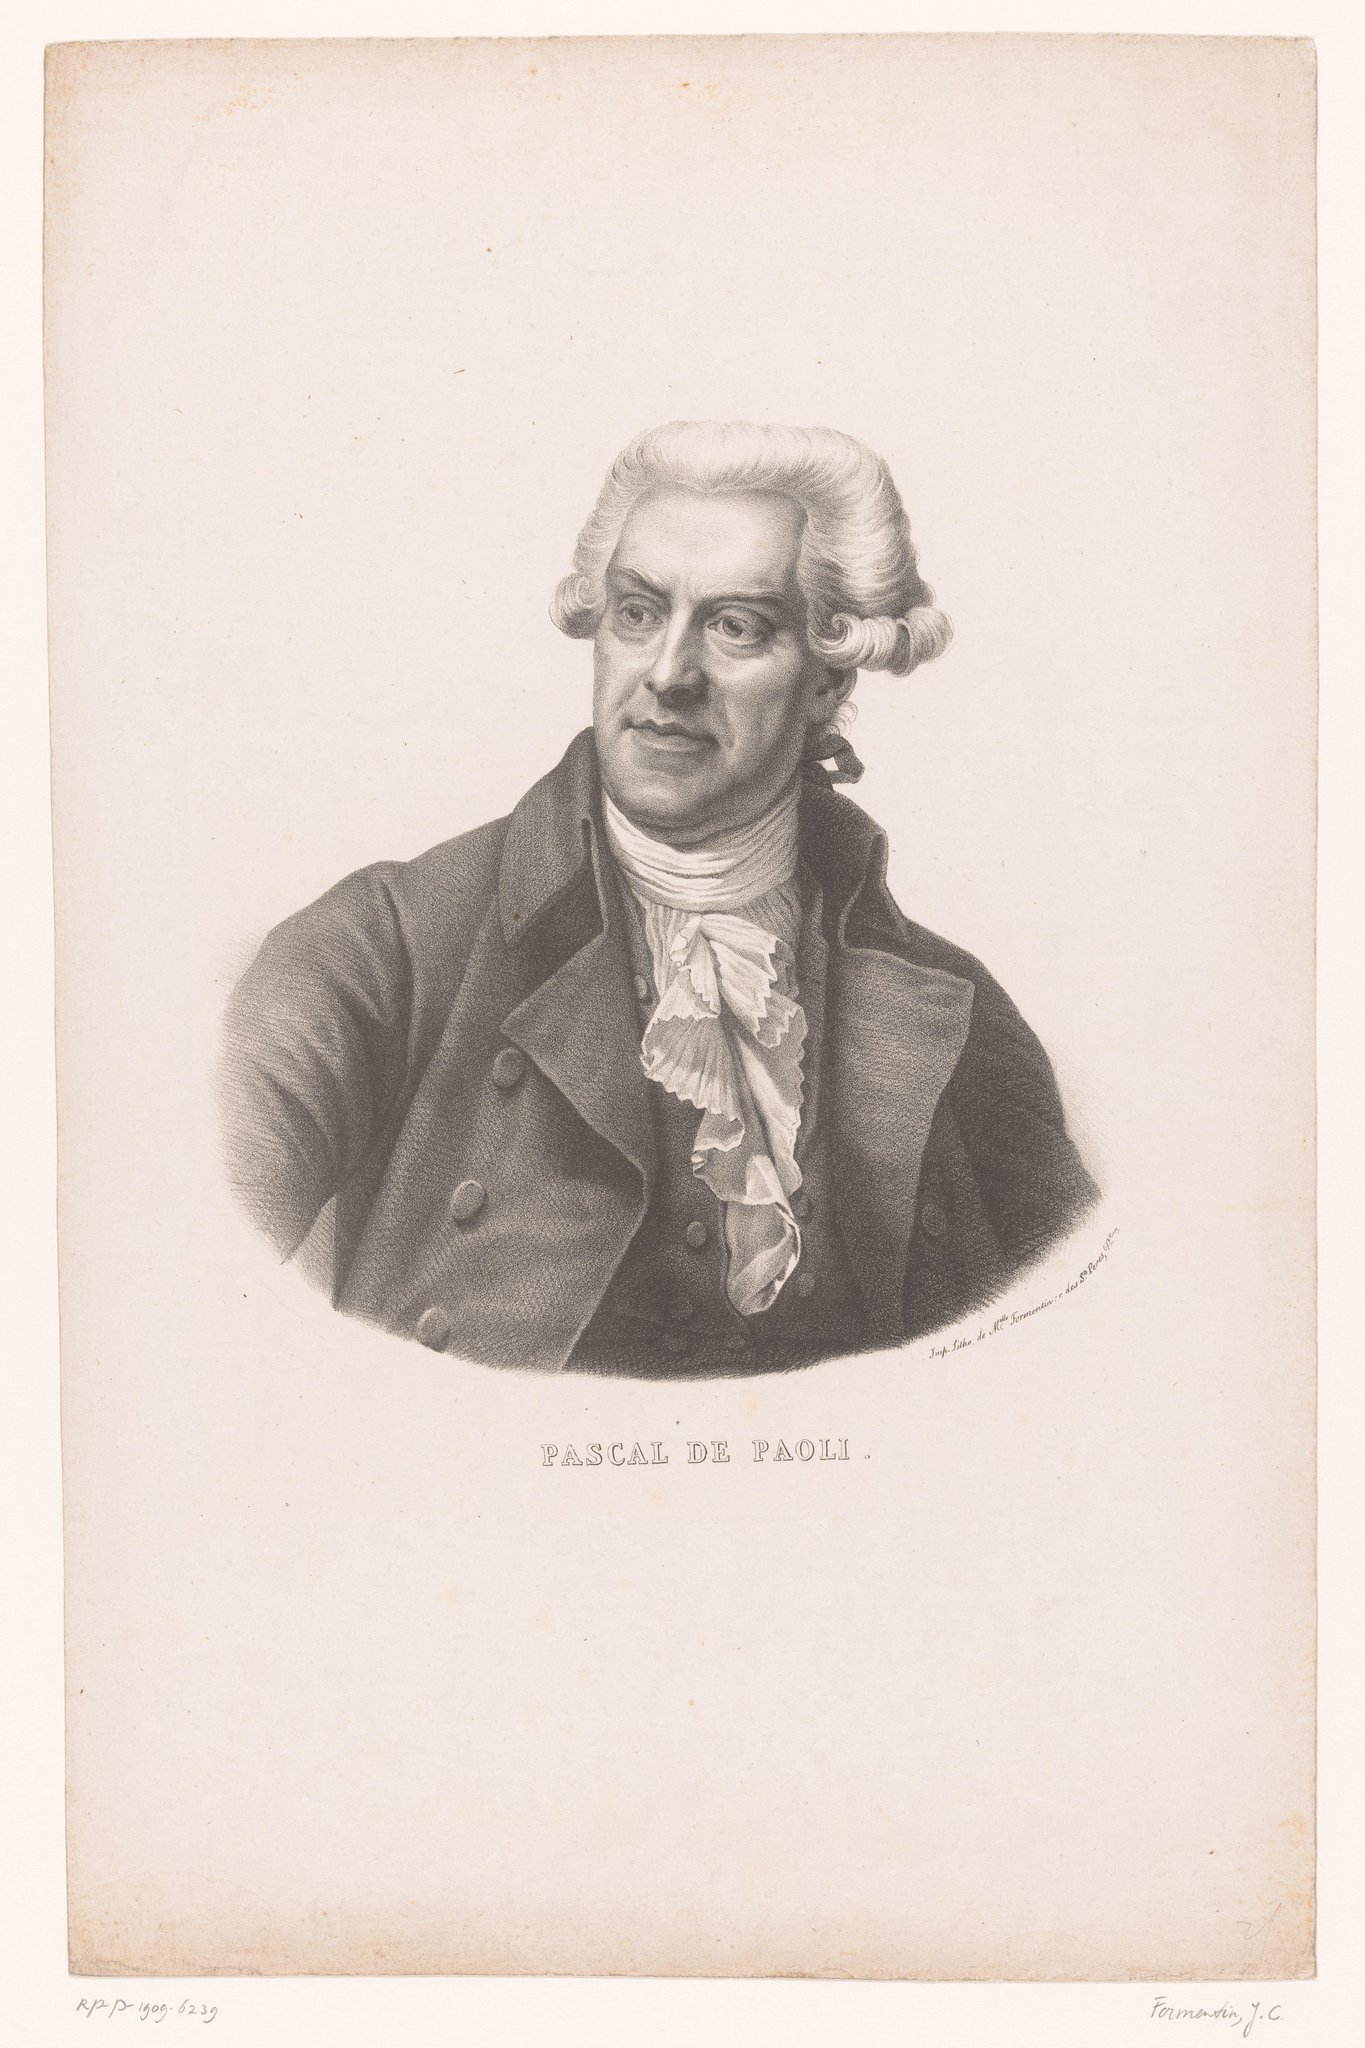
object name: print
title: Pascal de Paoli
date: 1824-1841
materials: paper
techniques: lithograph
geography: paris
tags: london, historical persons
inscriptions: collector's mark: Lugt 2228a